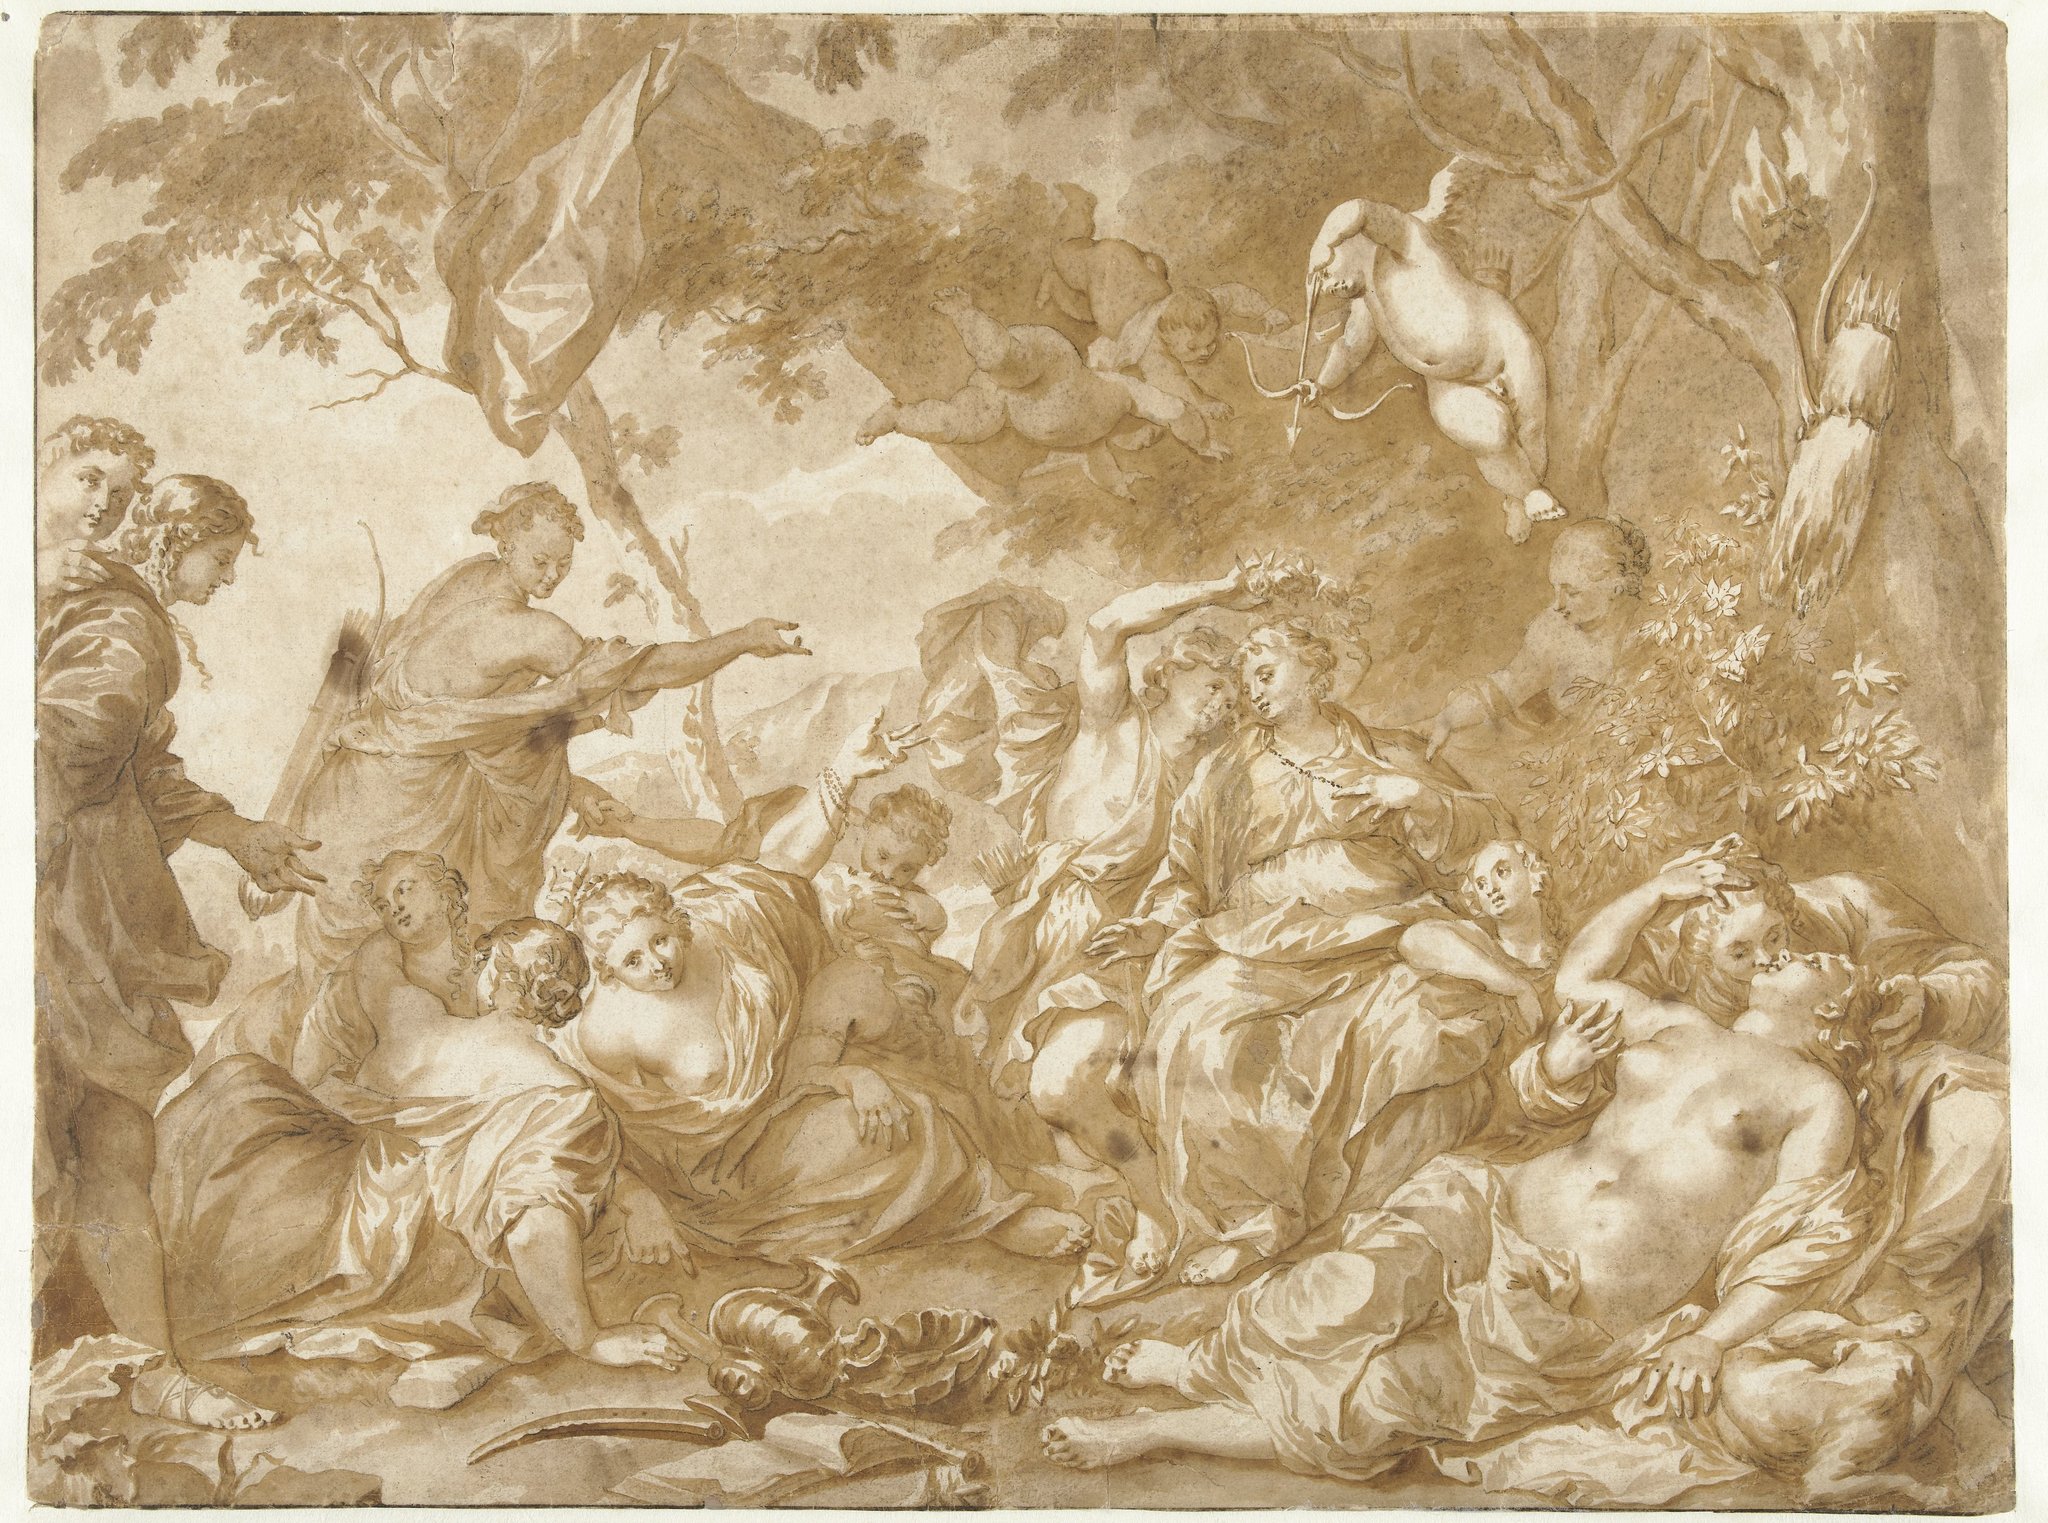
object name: drawing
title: Amaryllis en Myrtillo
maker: jan de bisschop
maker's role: draughtsman, print maker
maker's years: 1628-1671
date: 1648-1671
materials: chalk, ink, paper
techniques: brush, pen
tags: homosexual love - cc - homosexual love between women: lesbianism, (scenes from) specific works of literature: guarini, pastor fido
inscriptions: date: ‘1674’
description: Amaryllis en Myrtillo uit Guarini's "Il Pastor Fido".